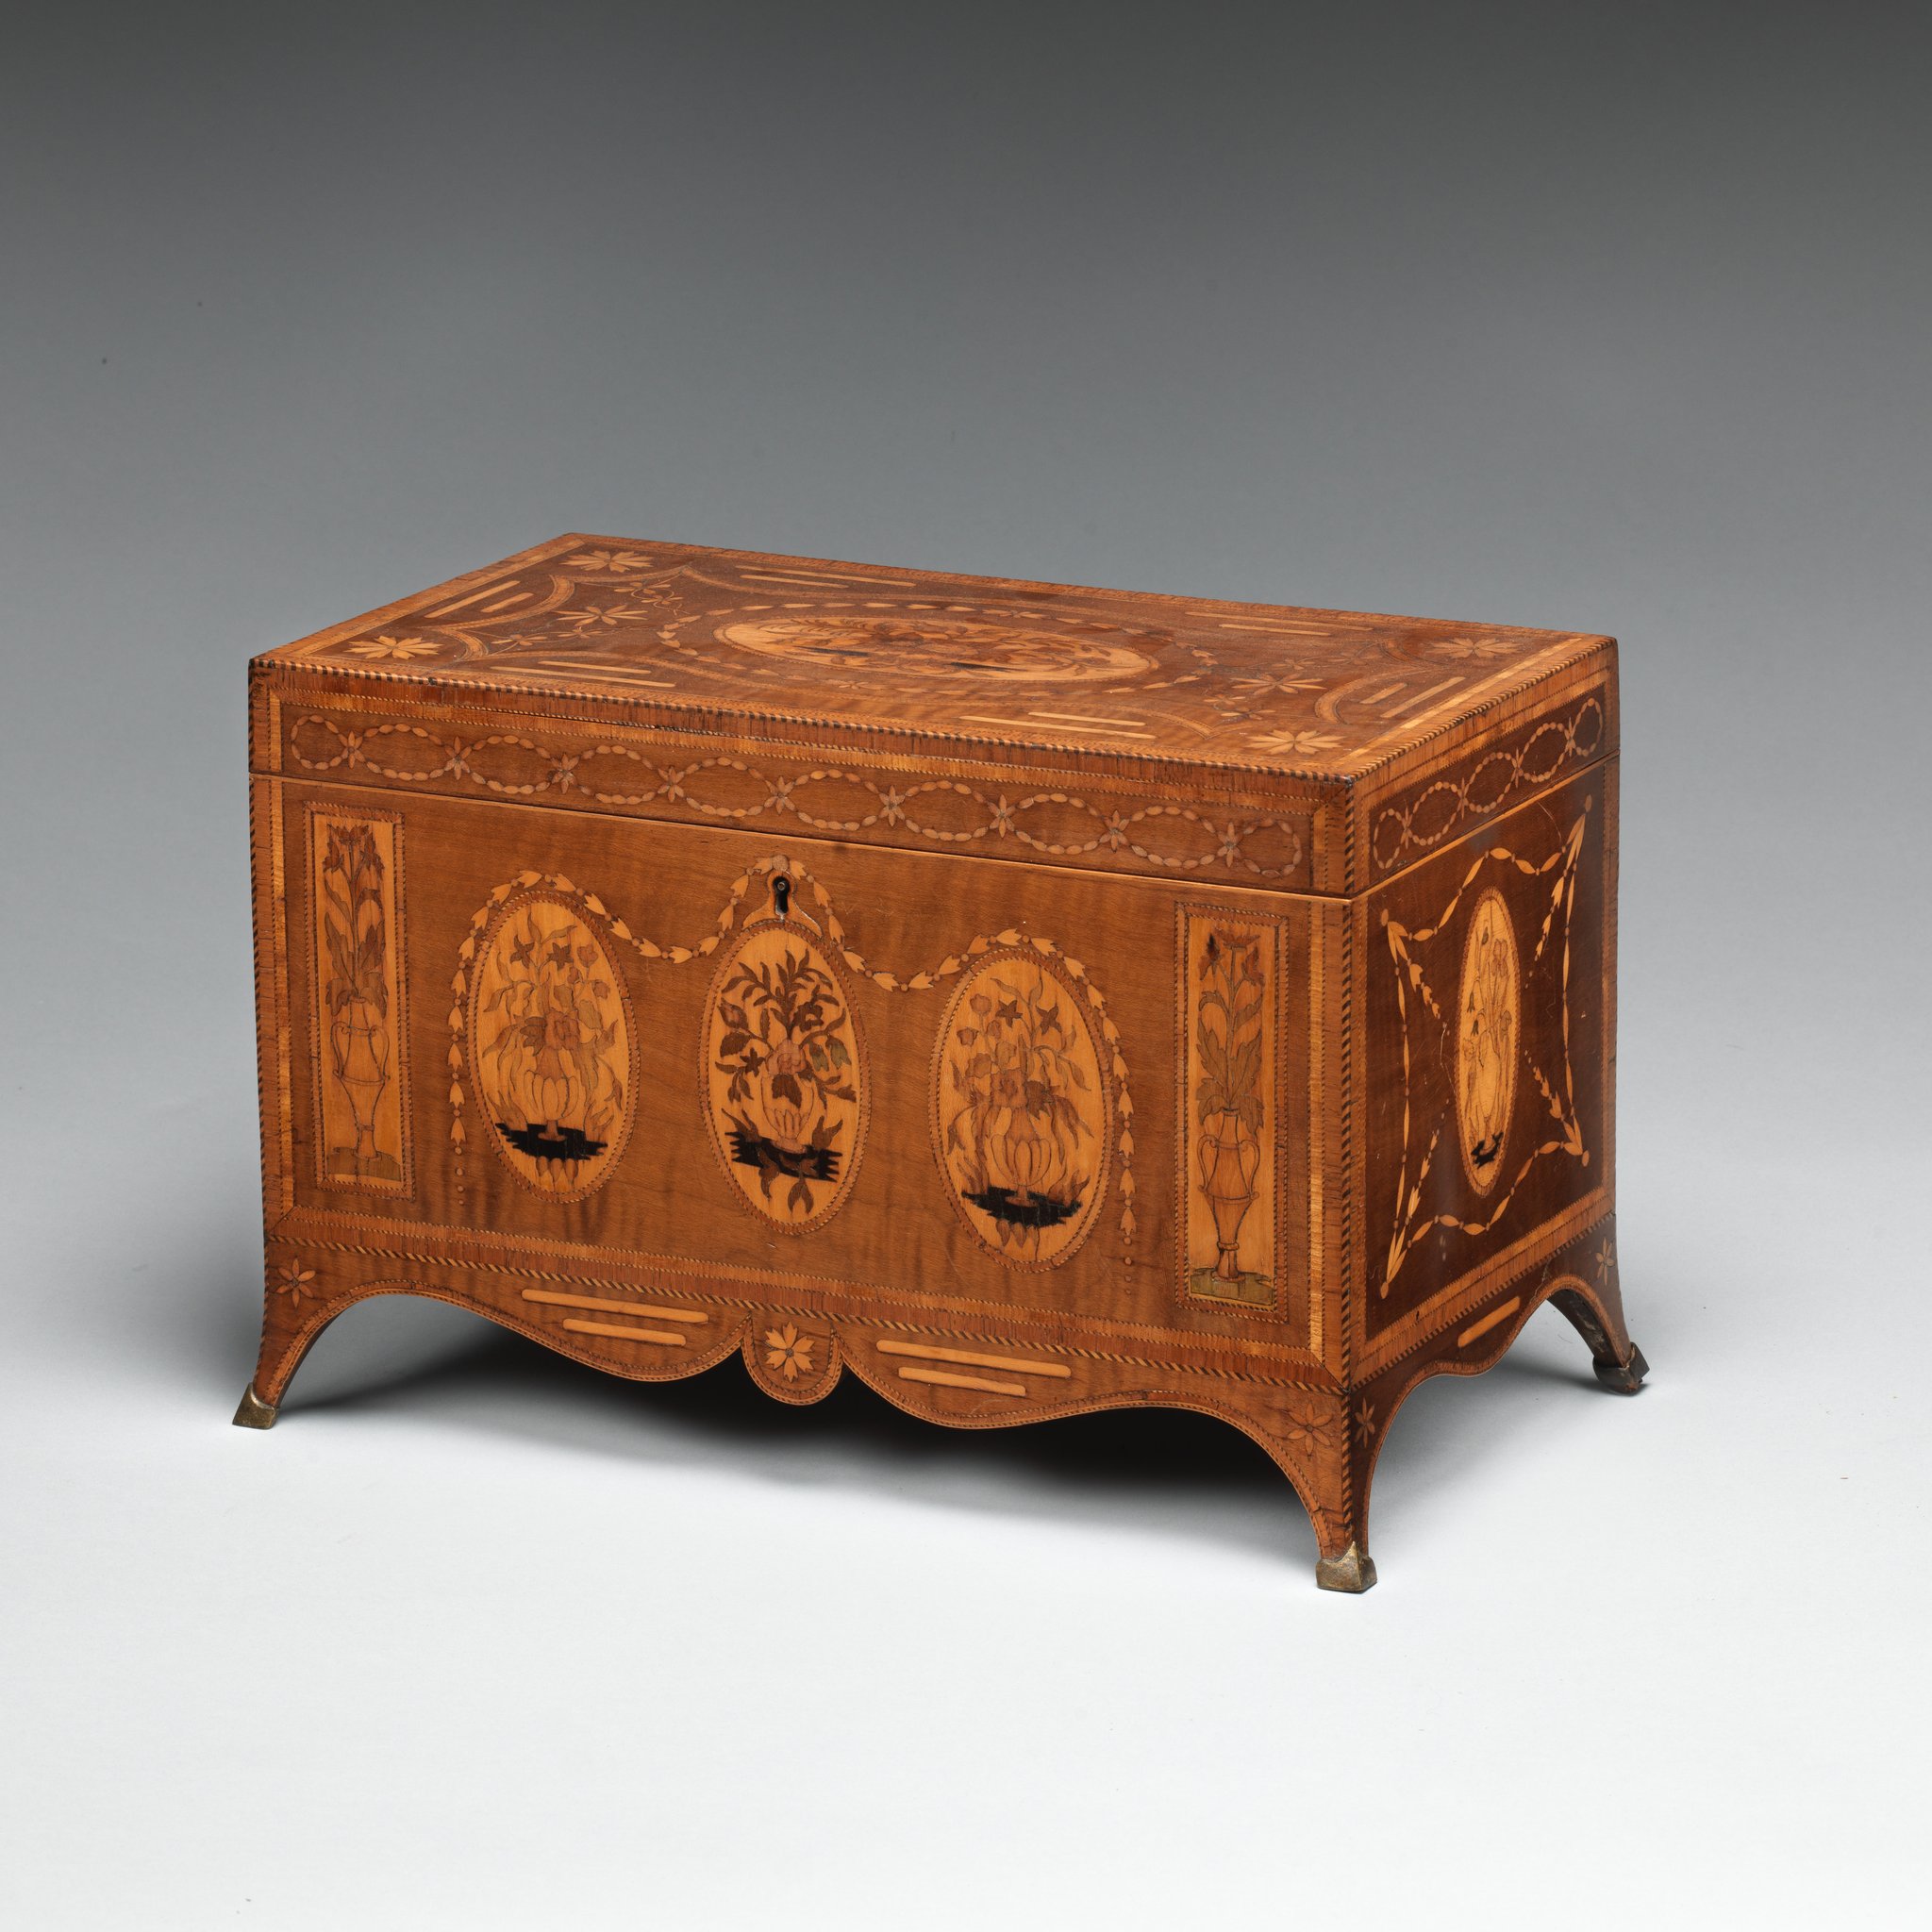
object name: tea chest with tea caddy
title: Tea chest with tea caddies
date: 1790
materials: wood, foil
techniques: lining, stain, veneering